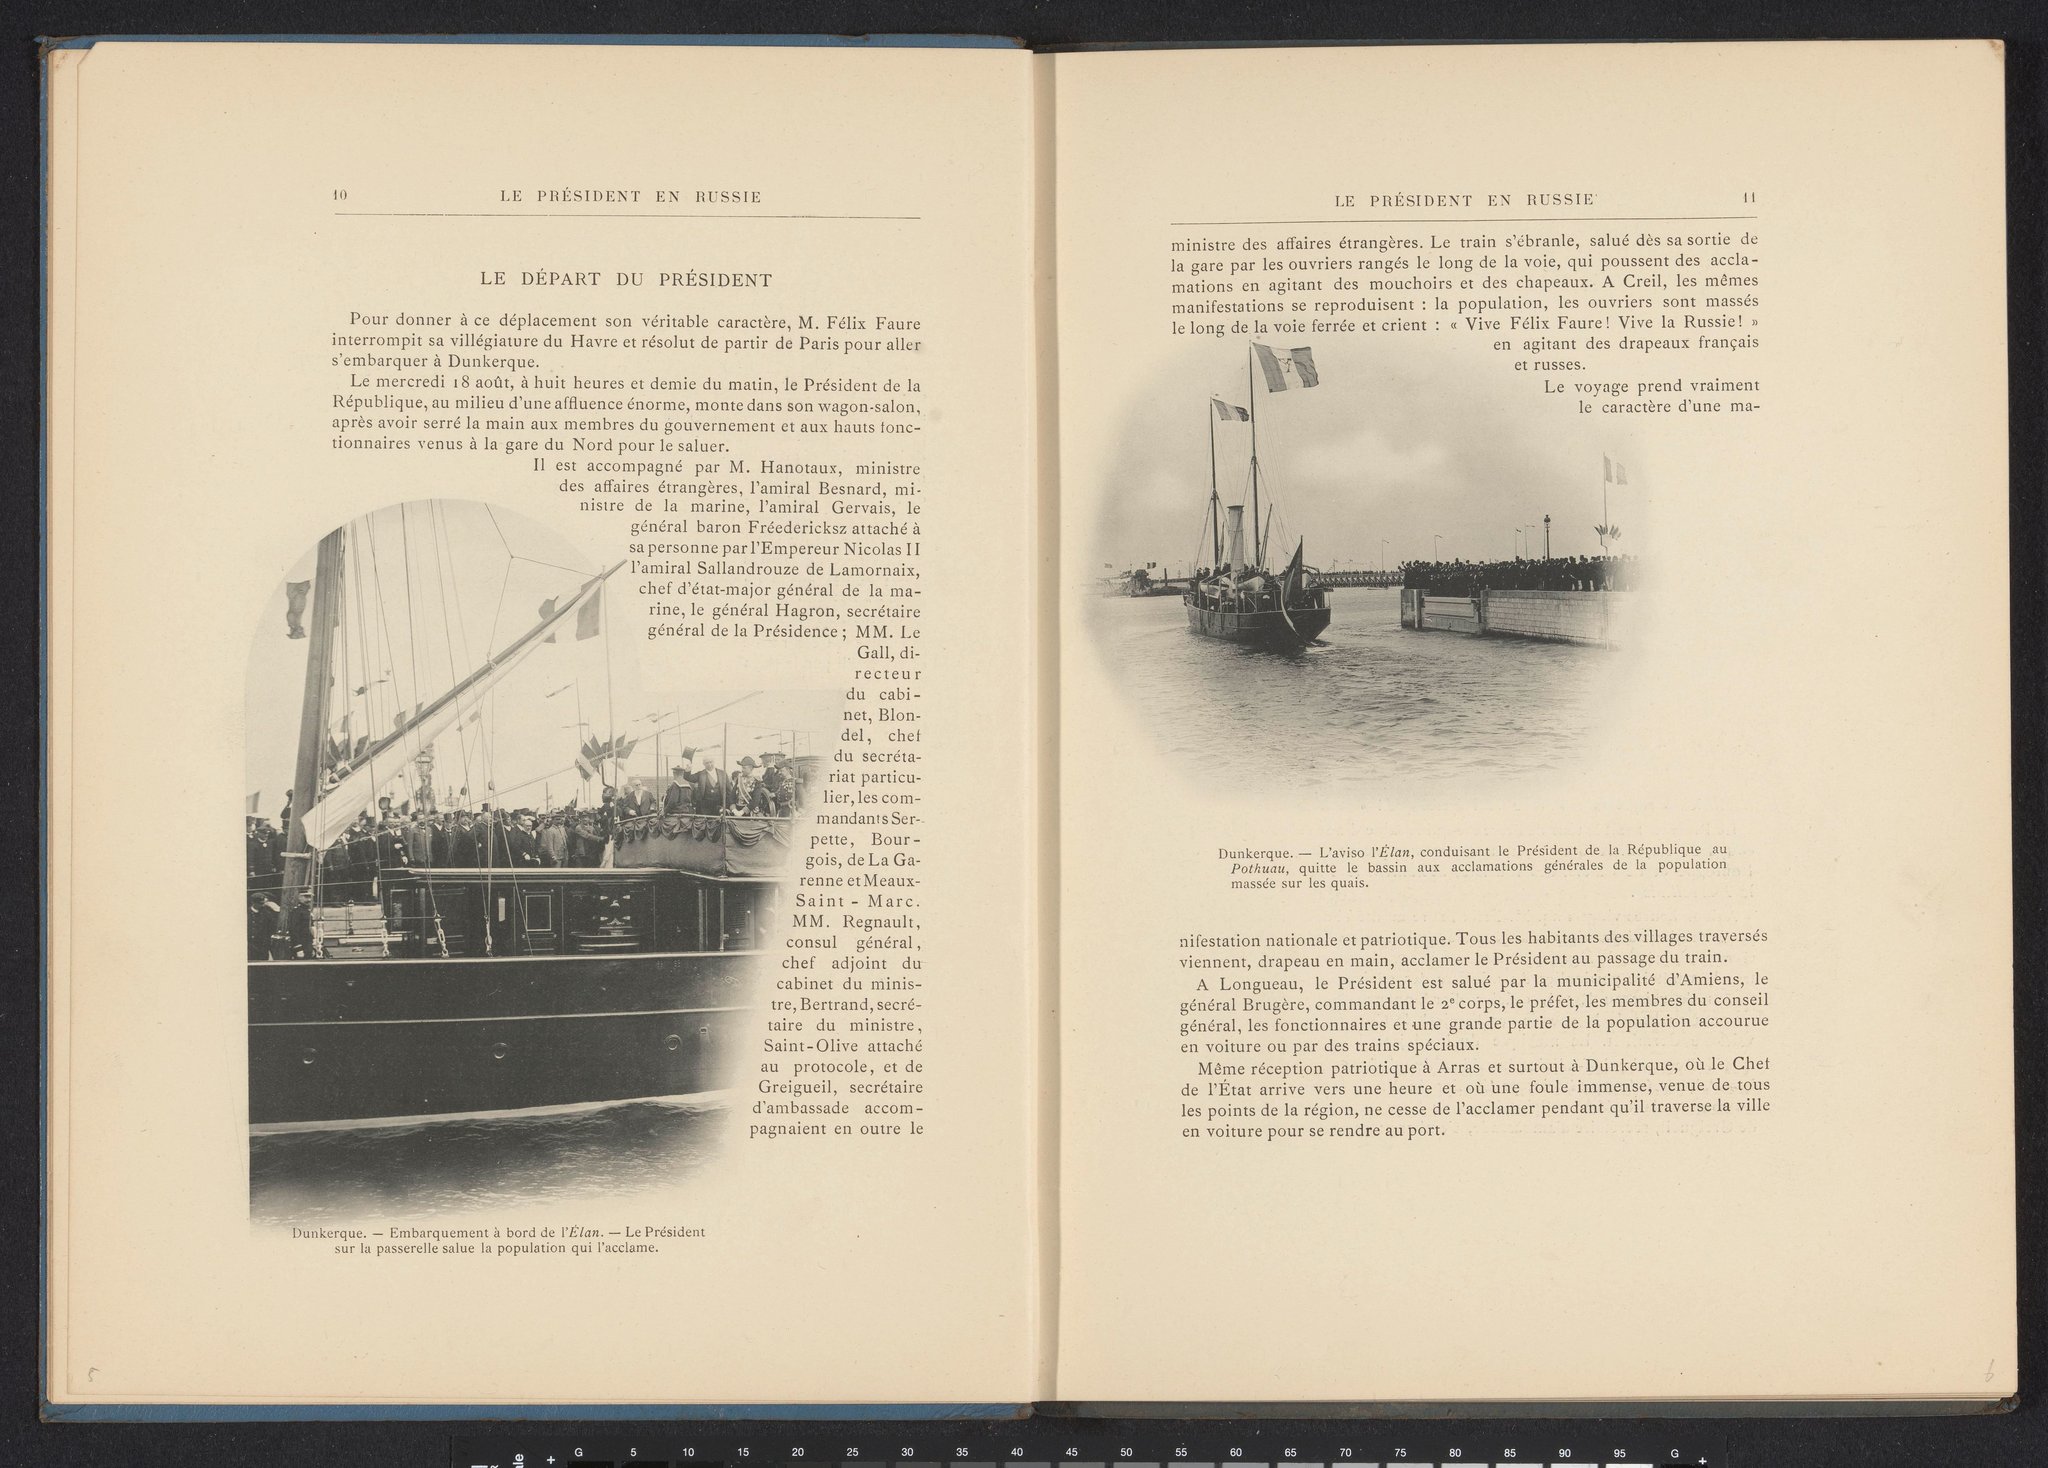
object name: photomechanical print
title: Zeilschip Élan met president Felix Faure aan boord vertrekt vanuit Duinkerke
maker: Anonymous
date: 1897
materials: paper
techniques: photograph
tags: sailing-ship, sailing-boat, ruler, sovereign, departure ~ travelling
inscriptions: inscription: ‘Dunkerque.- sur les quais.’